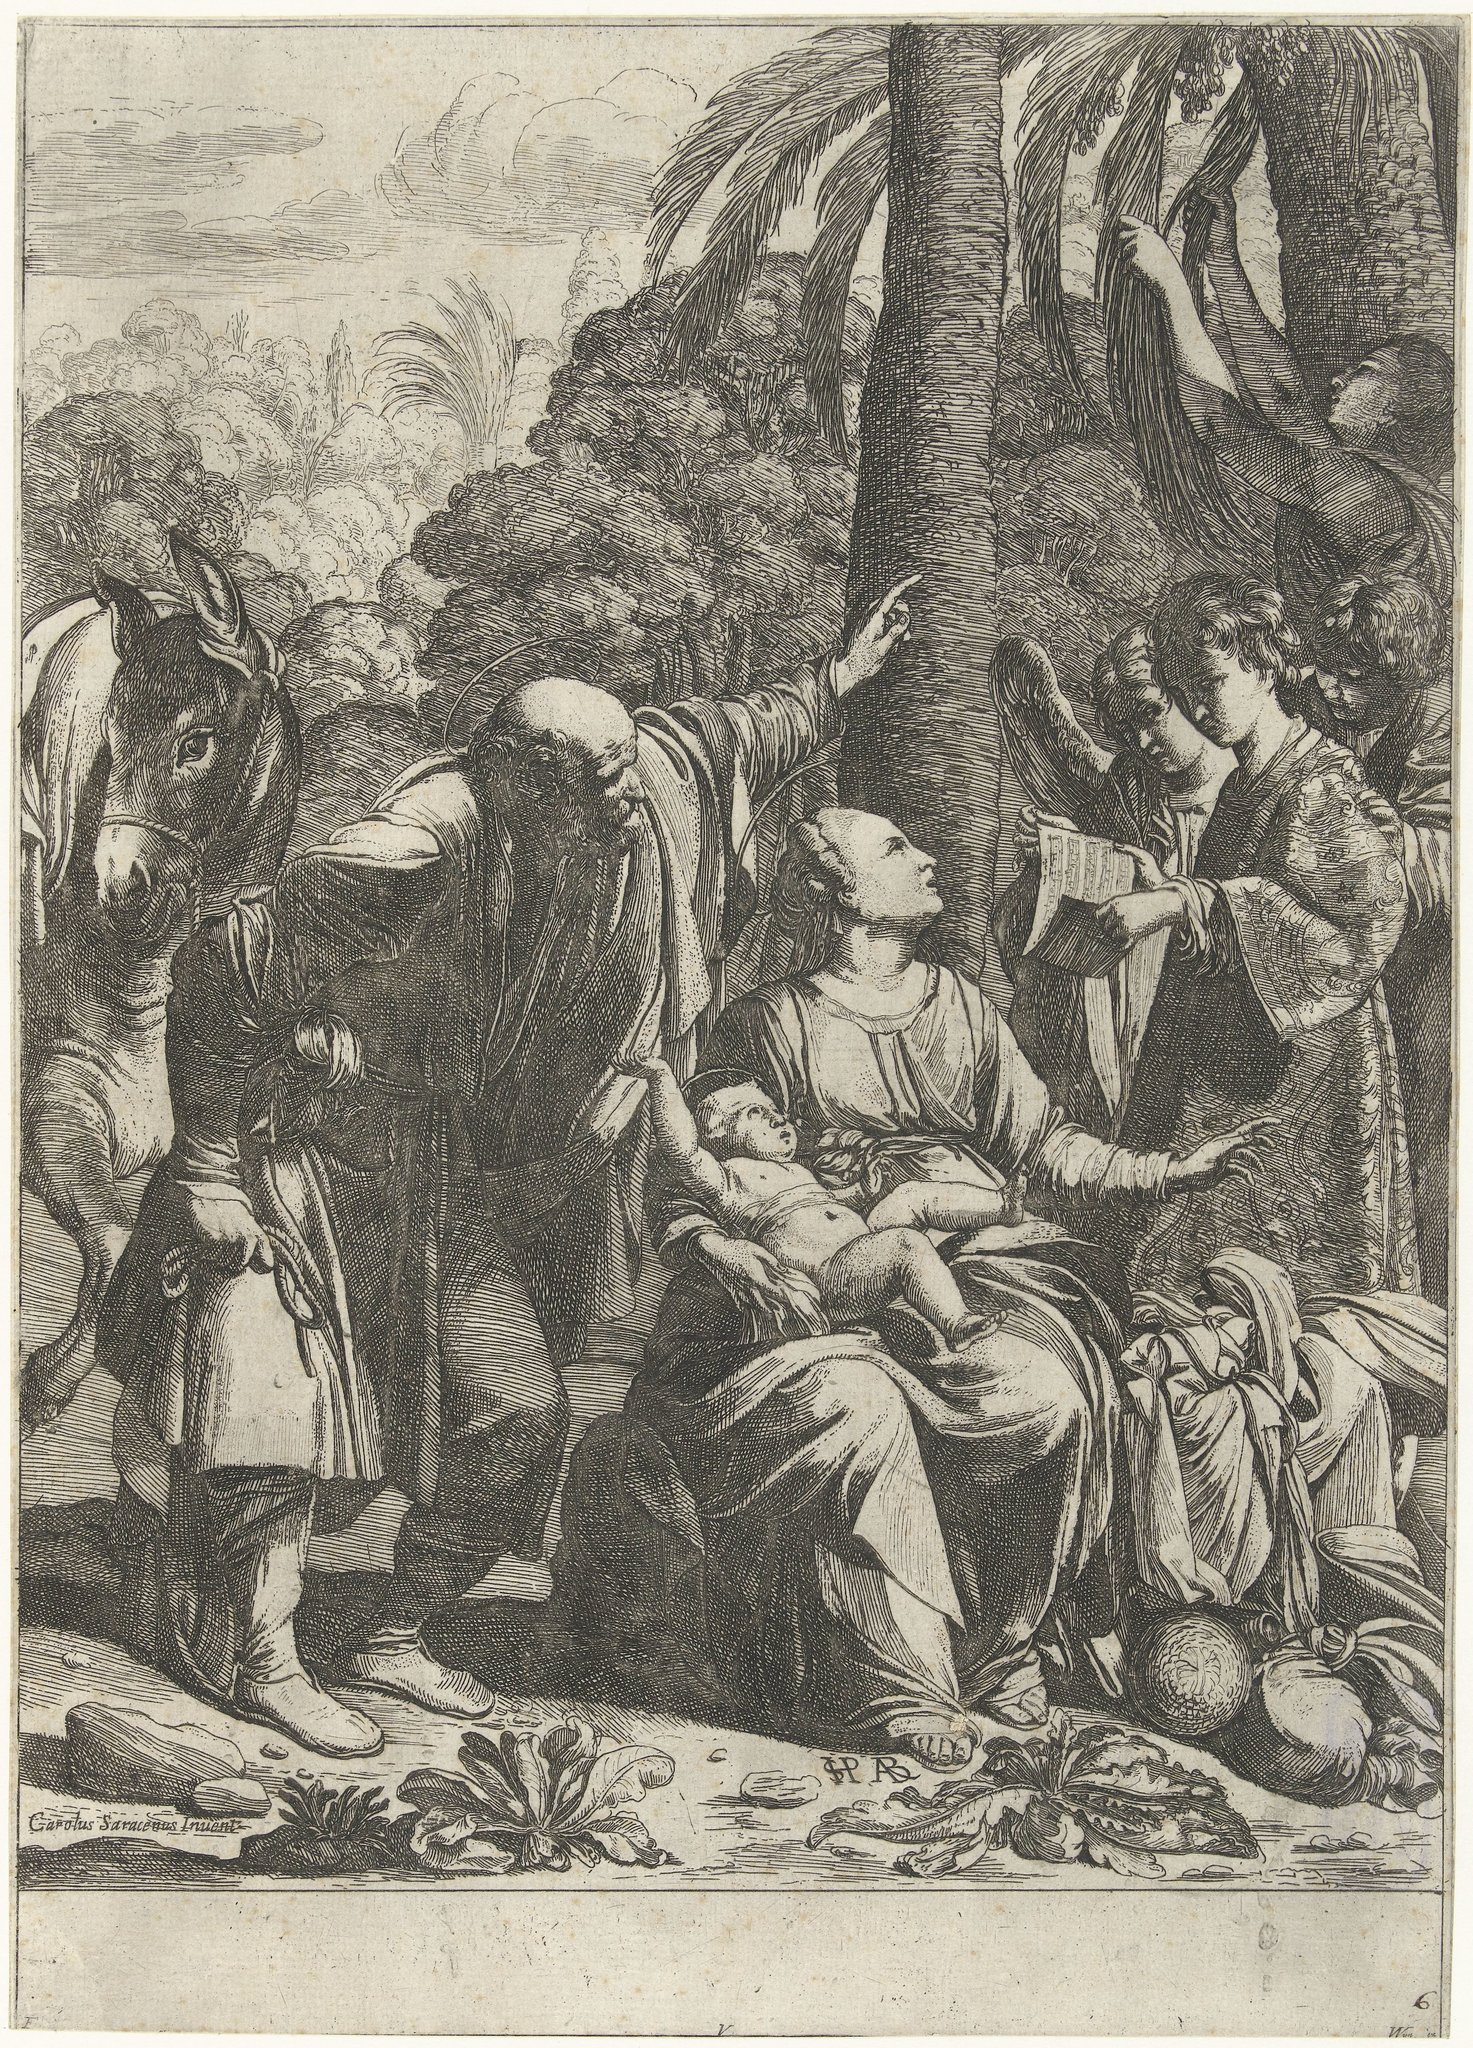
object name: print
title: Rest on the Flight into Egypt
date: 1606-1700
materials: paper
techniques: etching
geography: low countries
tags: rest on the flight into egypt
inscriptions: number: ‘6’, collector's mark: Lugt 10, collector's mark: Lugt 11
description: Maria zittend bij een palmboom, het Christuskind op schoot. Links van haar Jozef, hij houdt de ezel aan een touw vast. Rechts van haar vier engelen.